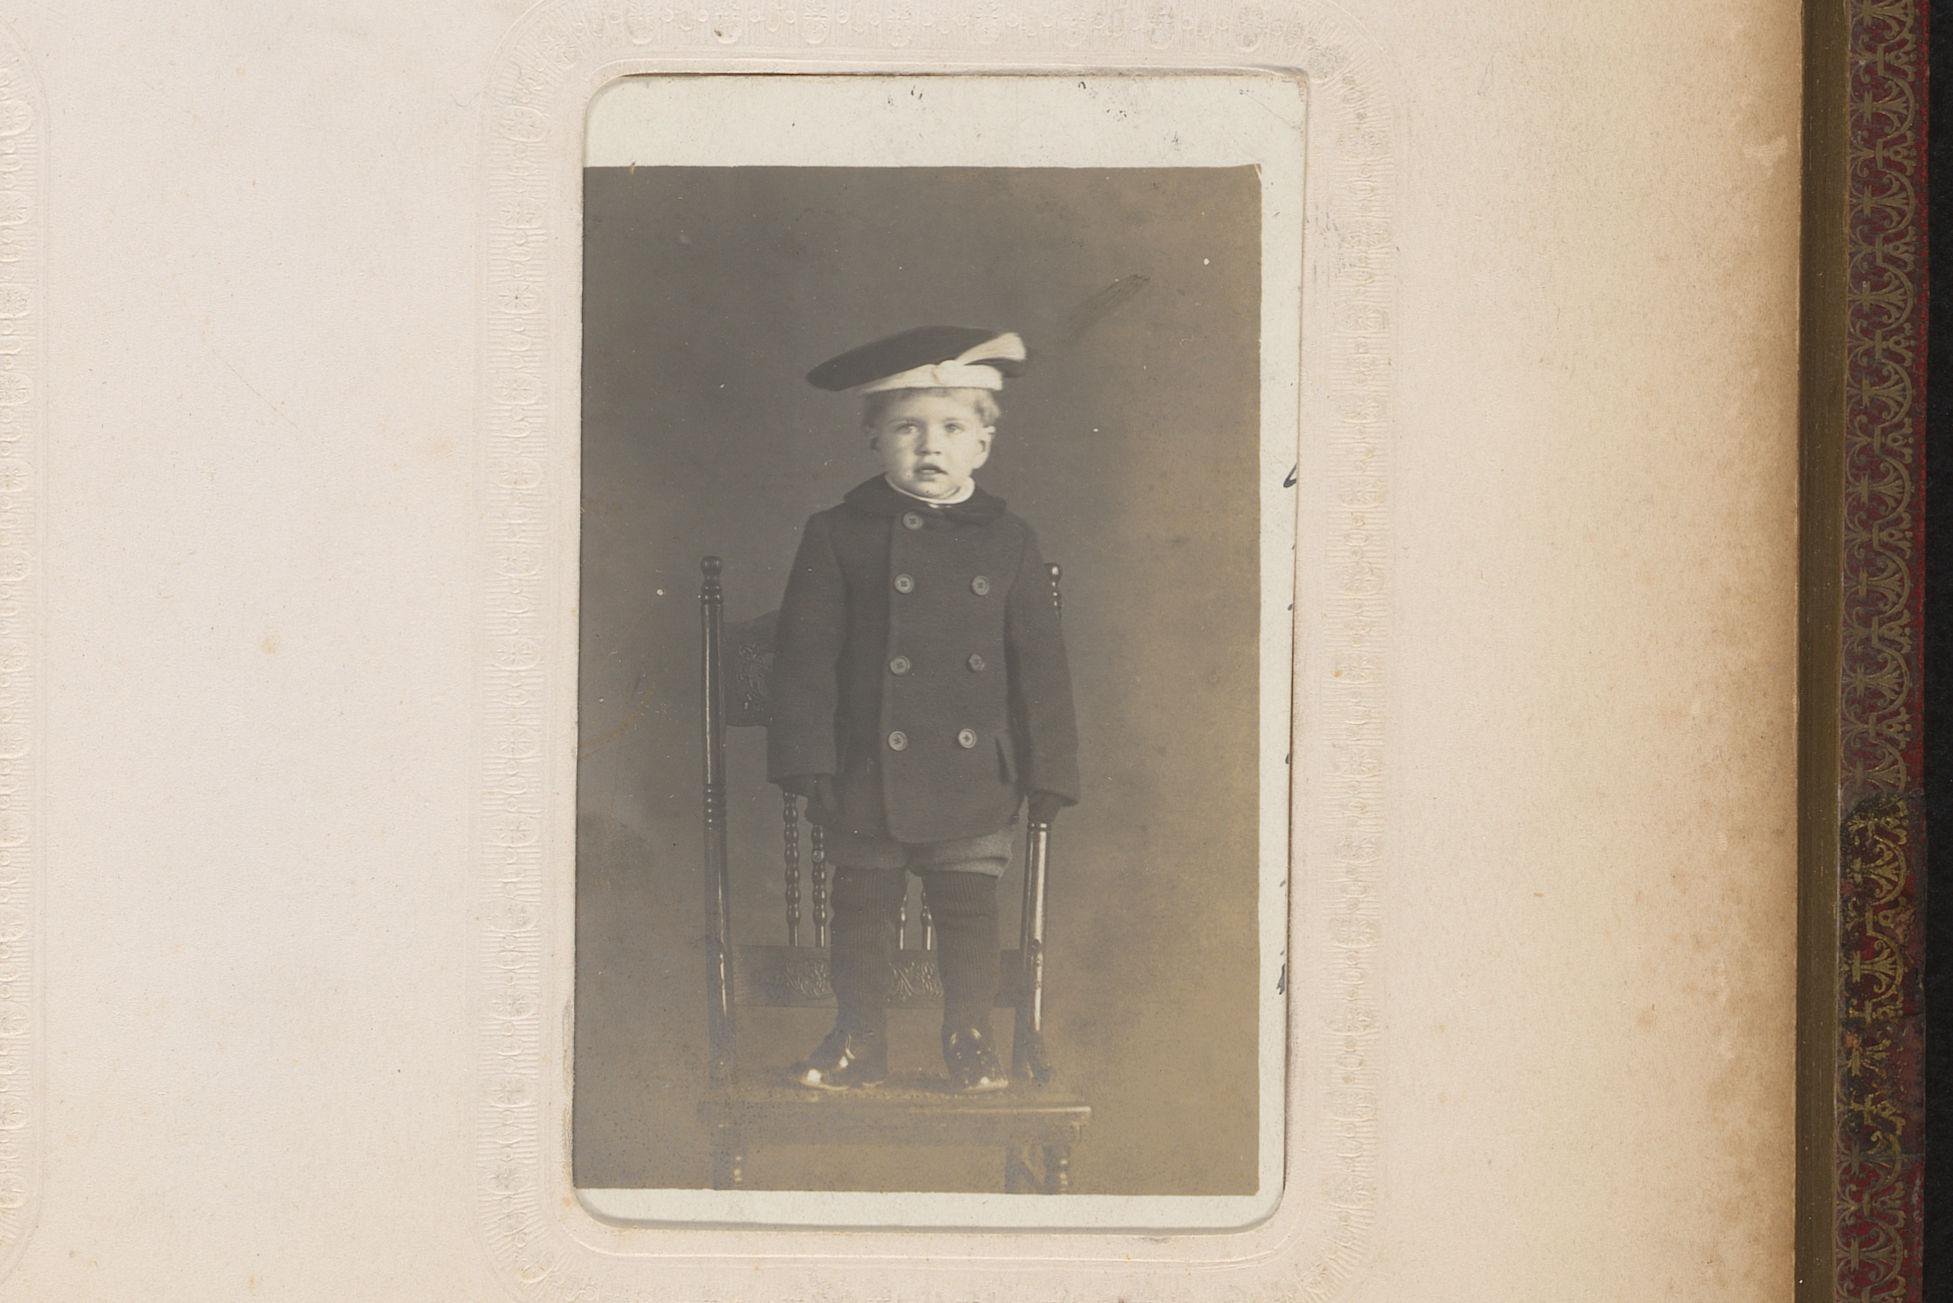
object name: album leaf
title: Portret van een zittende baby in witte jurk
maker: Anonymous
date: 1860-1900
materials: cardboard, photographic support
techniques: albumen print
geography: netherlands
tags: sitting figure, historical persons, infant, baby ~ the ages of man